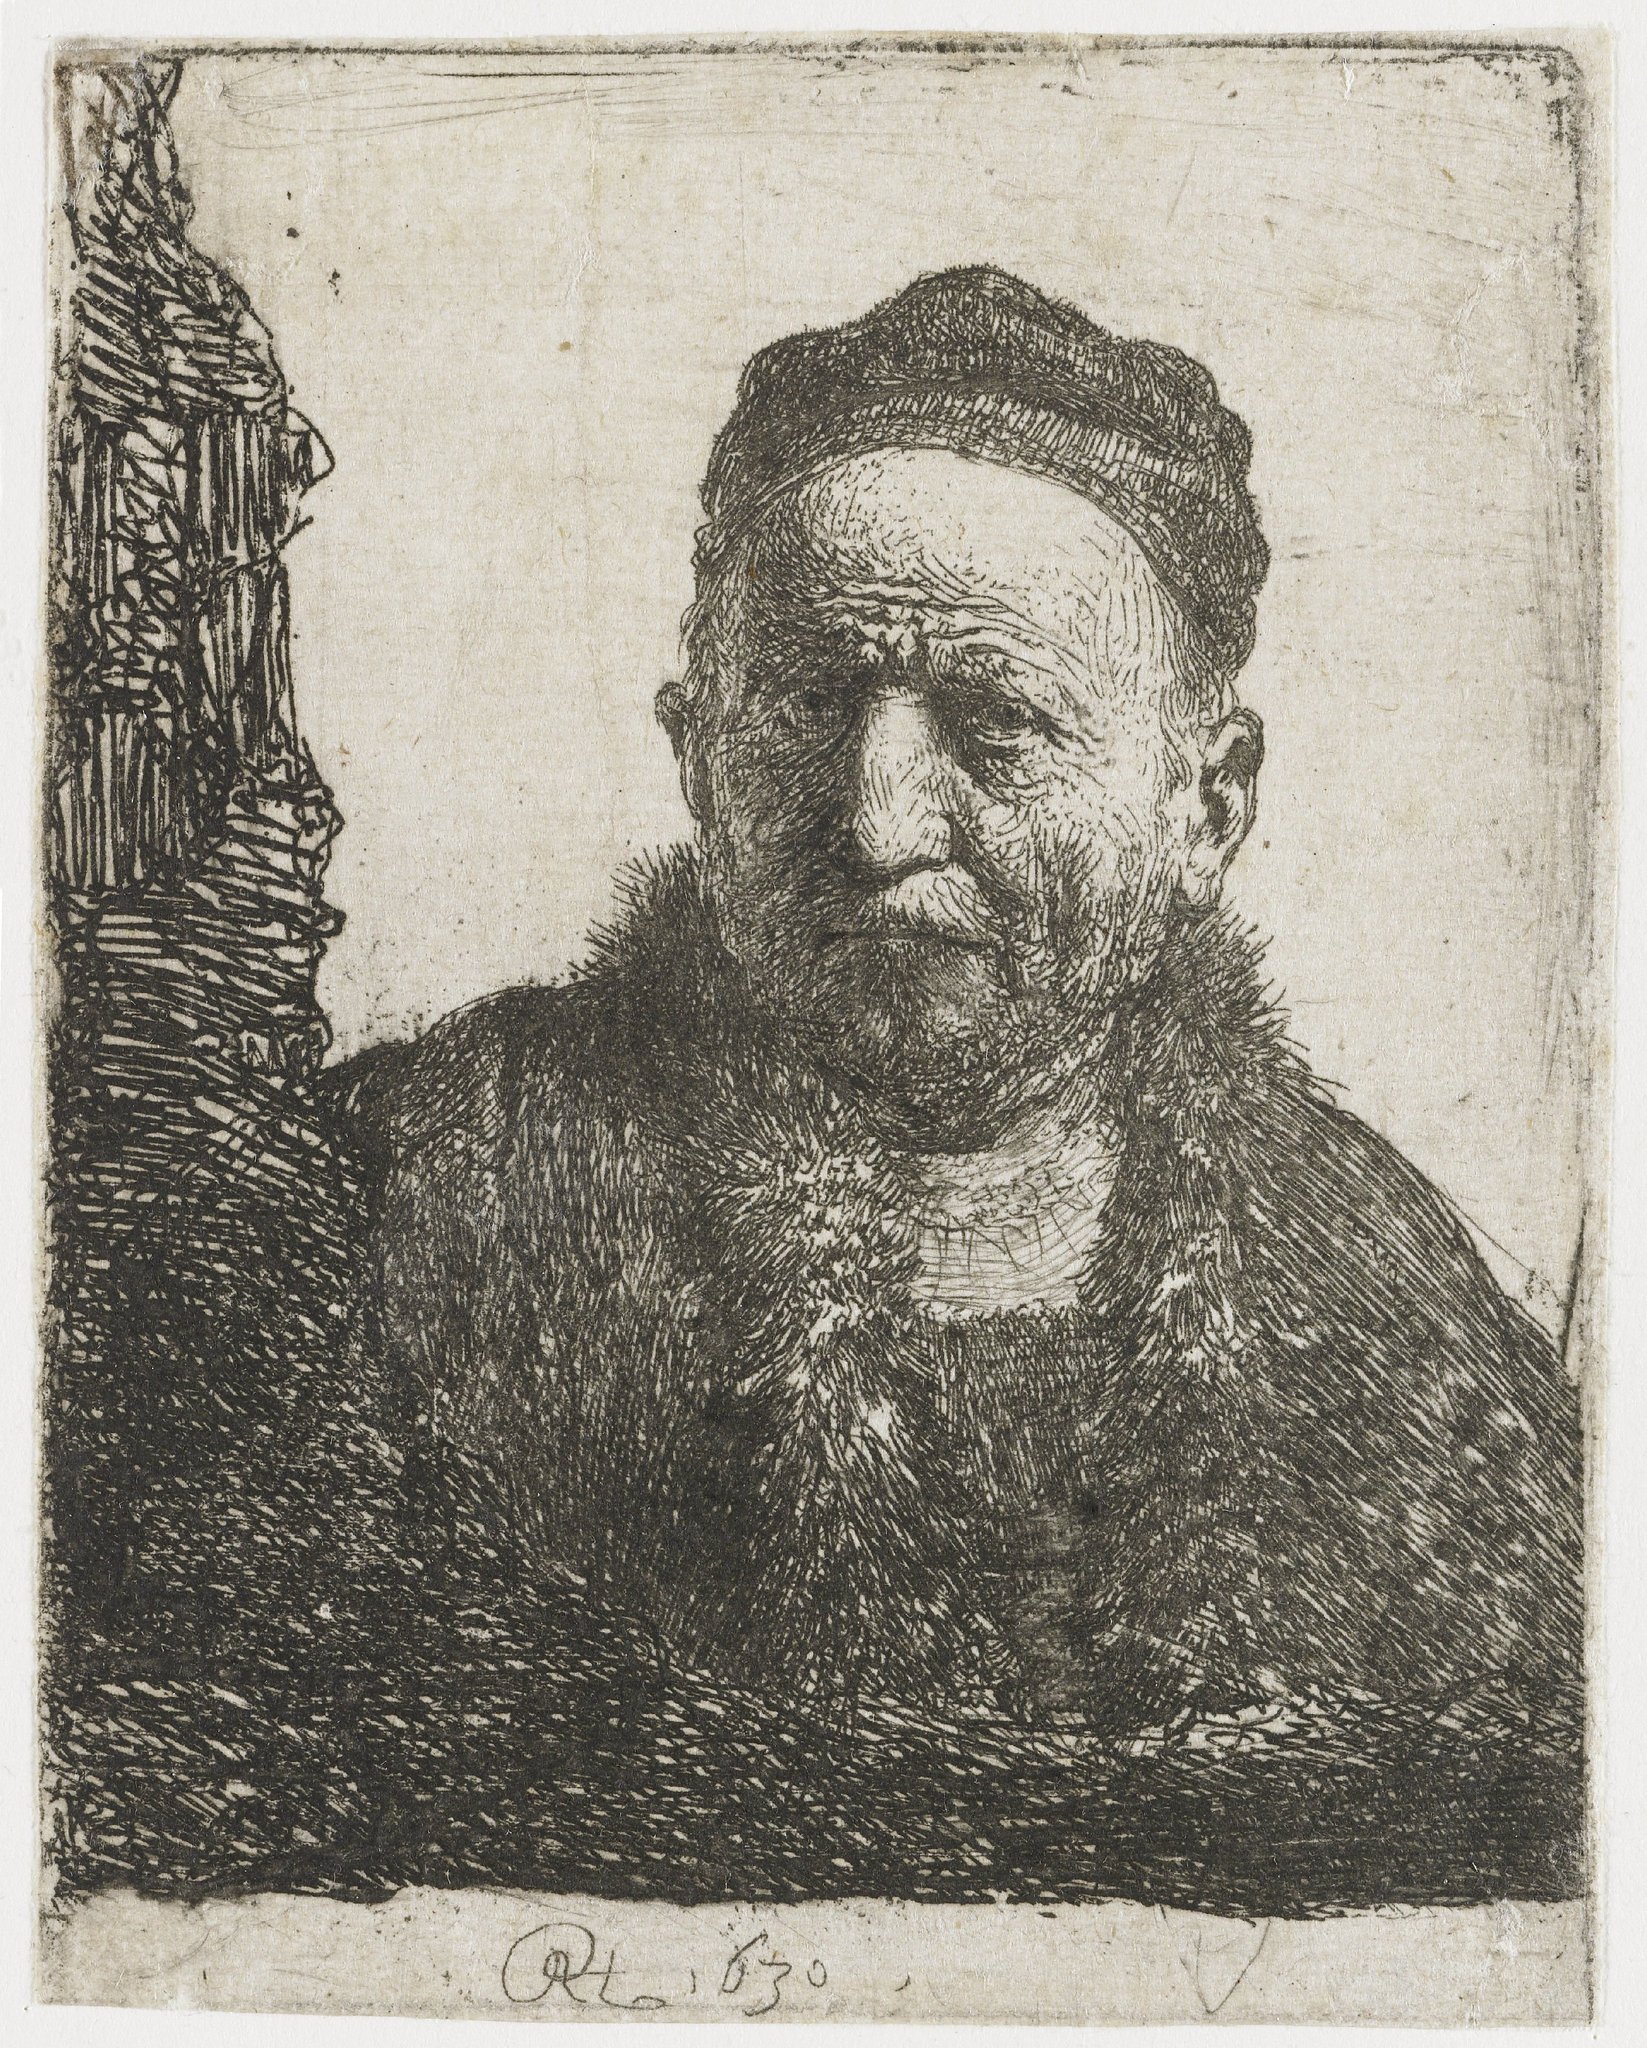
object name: print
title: Man wearing a close cap: bust (the artist's father?)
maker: rembrandt van rijn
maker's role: draughtsman, painter, print maker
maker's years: 1606-1669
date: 1630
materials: paper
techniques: etching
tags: leiden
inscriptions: monogram and date: ‘RHL 1630’, collector's mark: Lugt 2165